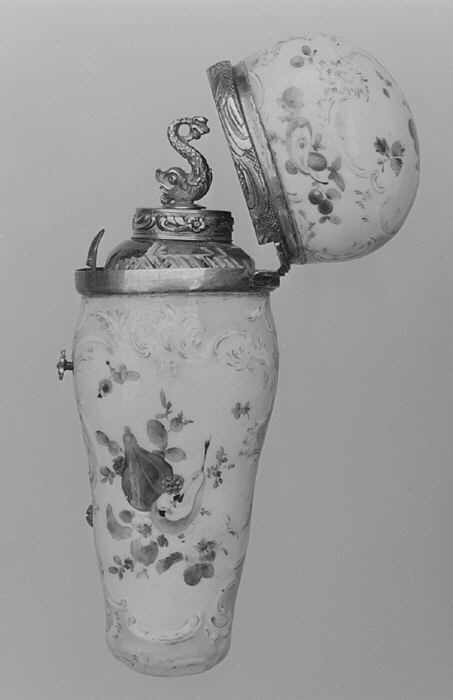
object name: étui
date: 1734-1766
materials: gilt copper, crystal, hard paste porcelain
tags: fish